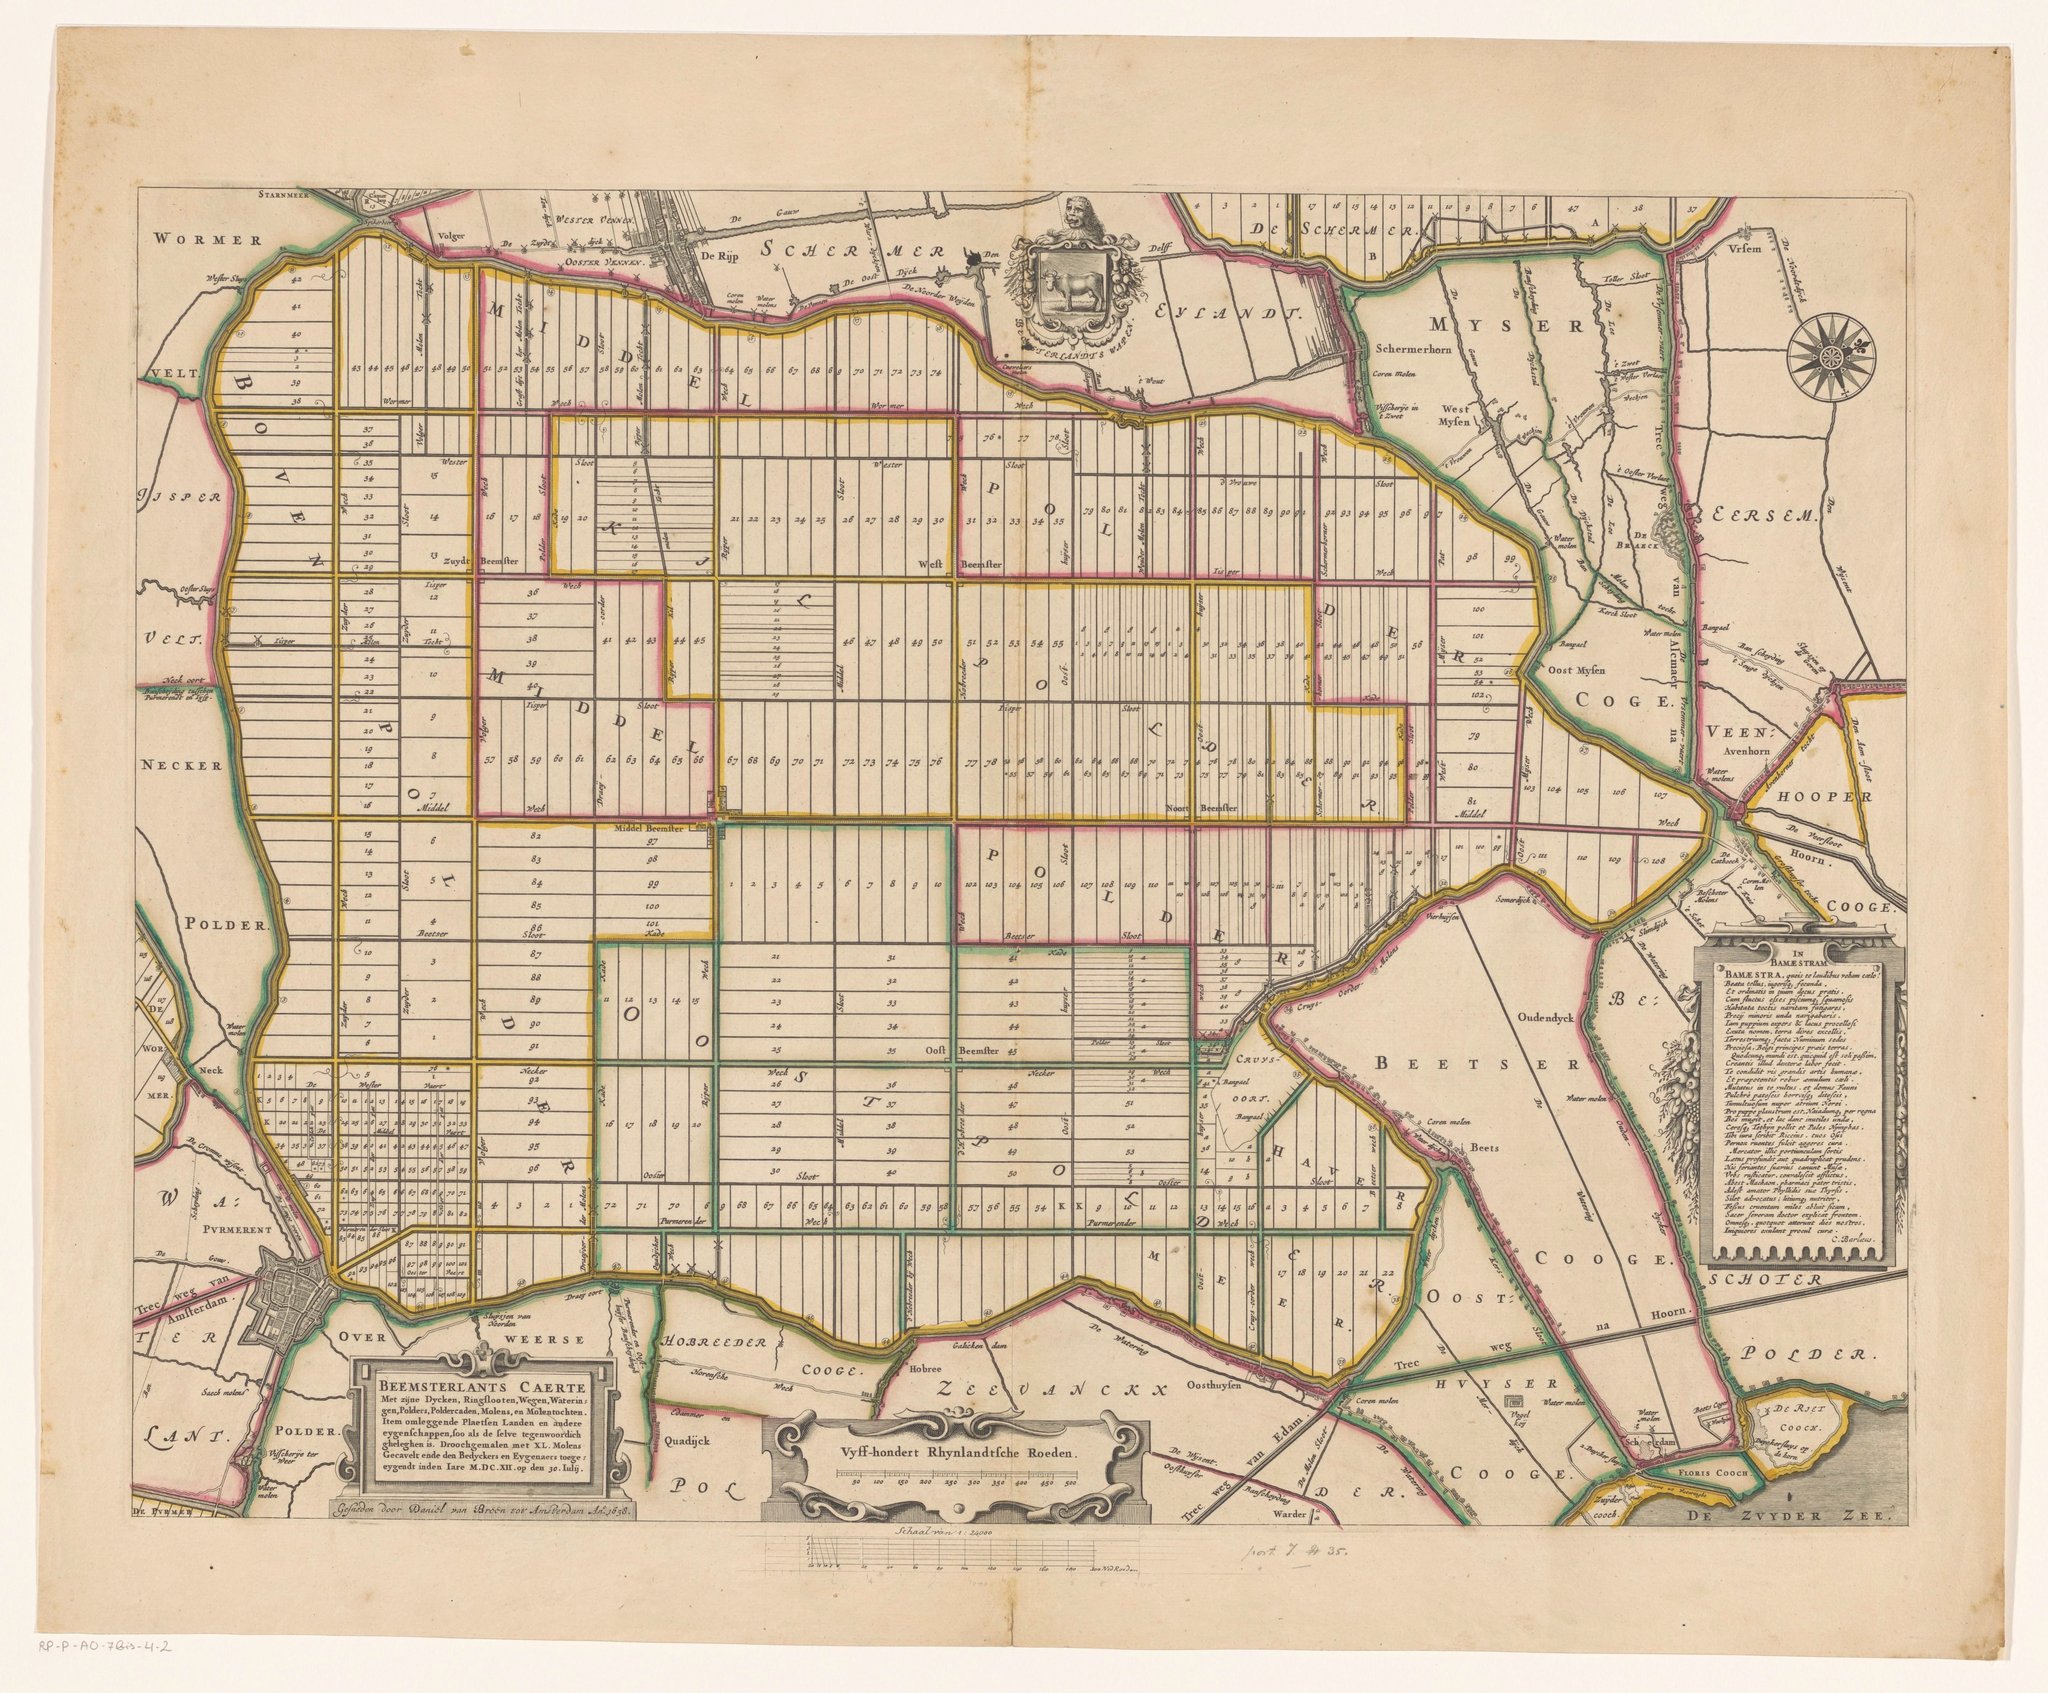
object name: map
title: Kaart van de Beemster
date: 1658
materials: ink, paper, pencil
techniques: engraving, hand coloring, pen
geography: amsterdam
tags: maps of separate countries or regions, beemster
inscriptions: inscription, collector's mark: Lugt 19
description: Kaart van de Beemster na de drooglegging (voltooid in 1612). Boven in het midden het wapen van de Beemster. Linksonder de titelcartouche, rechts daarvan een schaalstok: Vyff-hondert Rhynlandtsche roeden. Rechts een cartouche met een Latijns gedicht van Caspar van Baerle over de Beemster. Oriëntatie: noorden rechts.